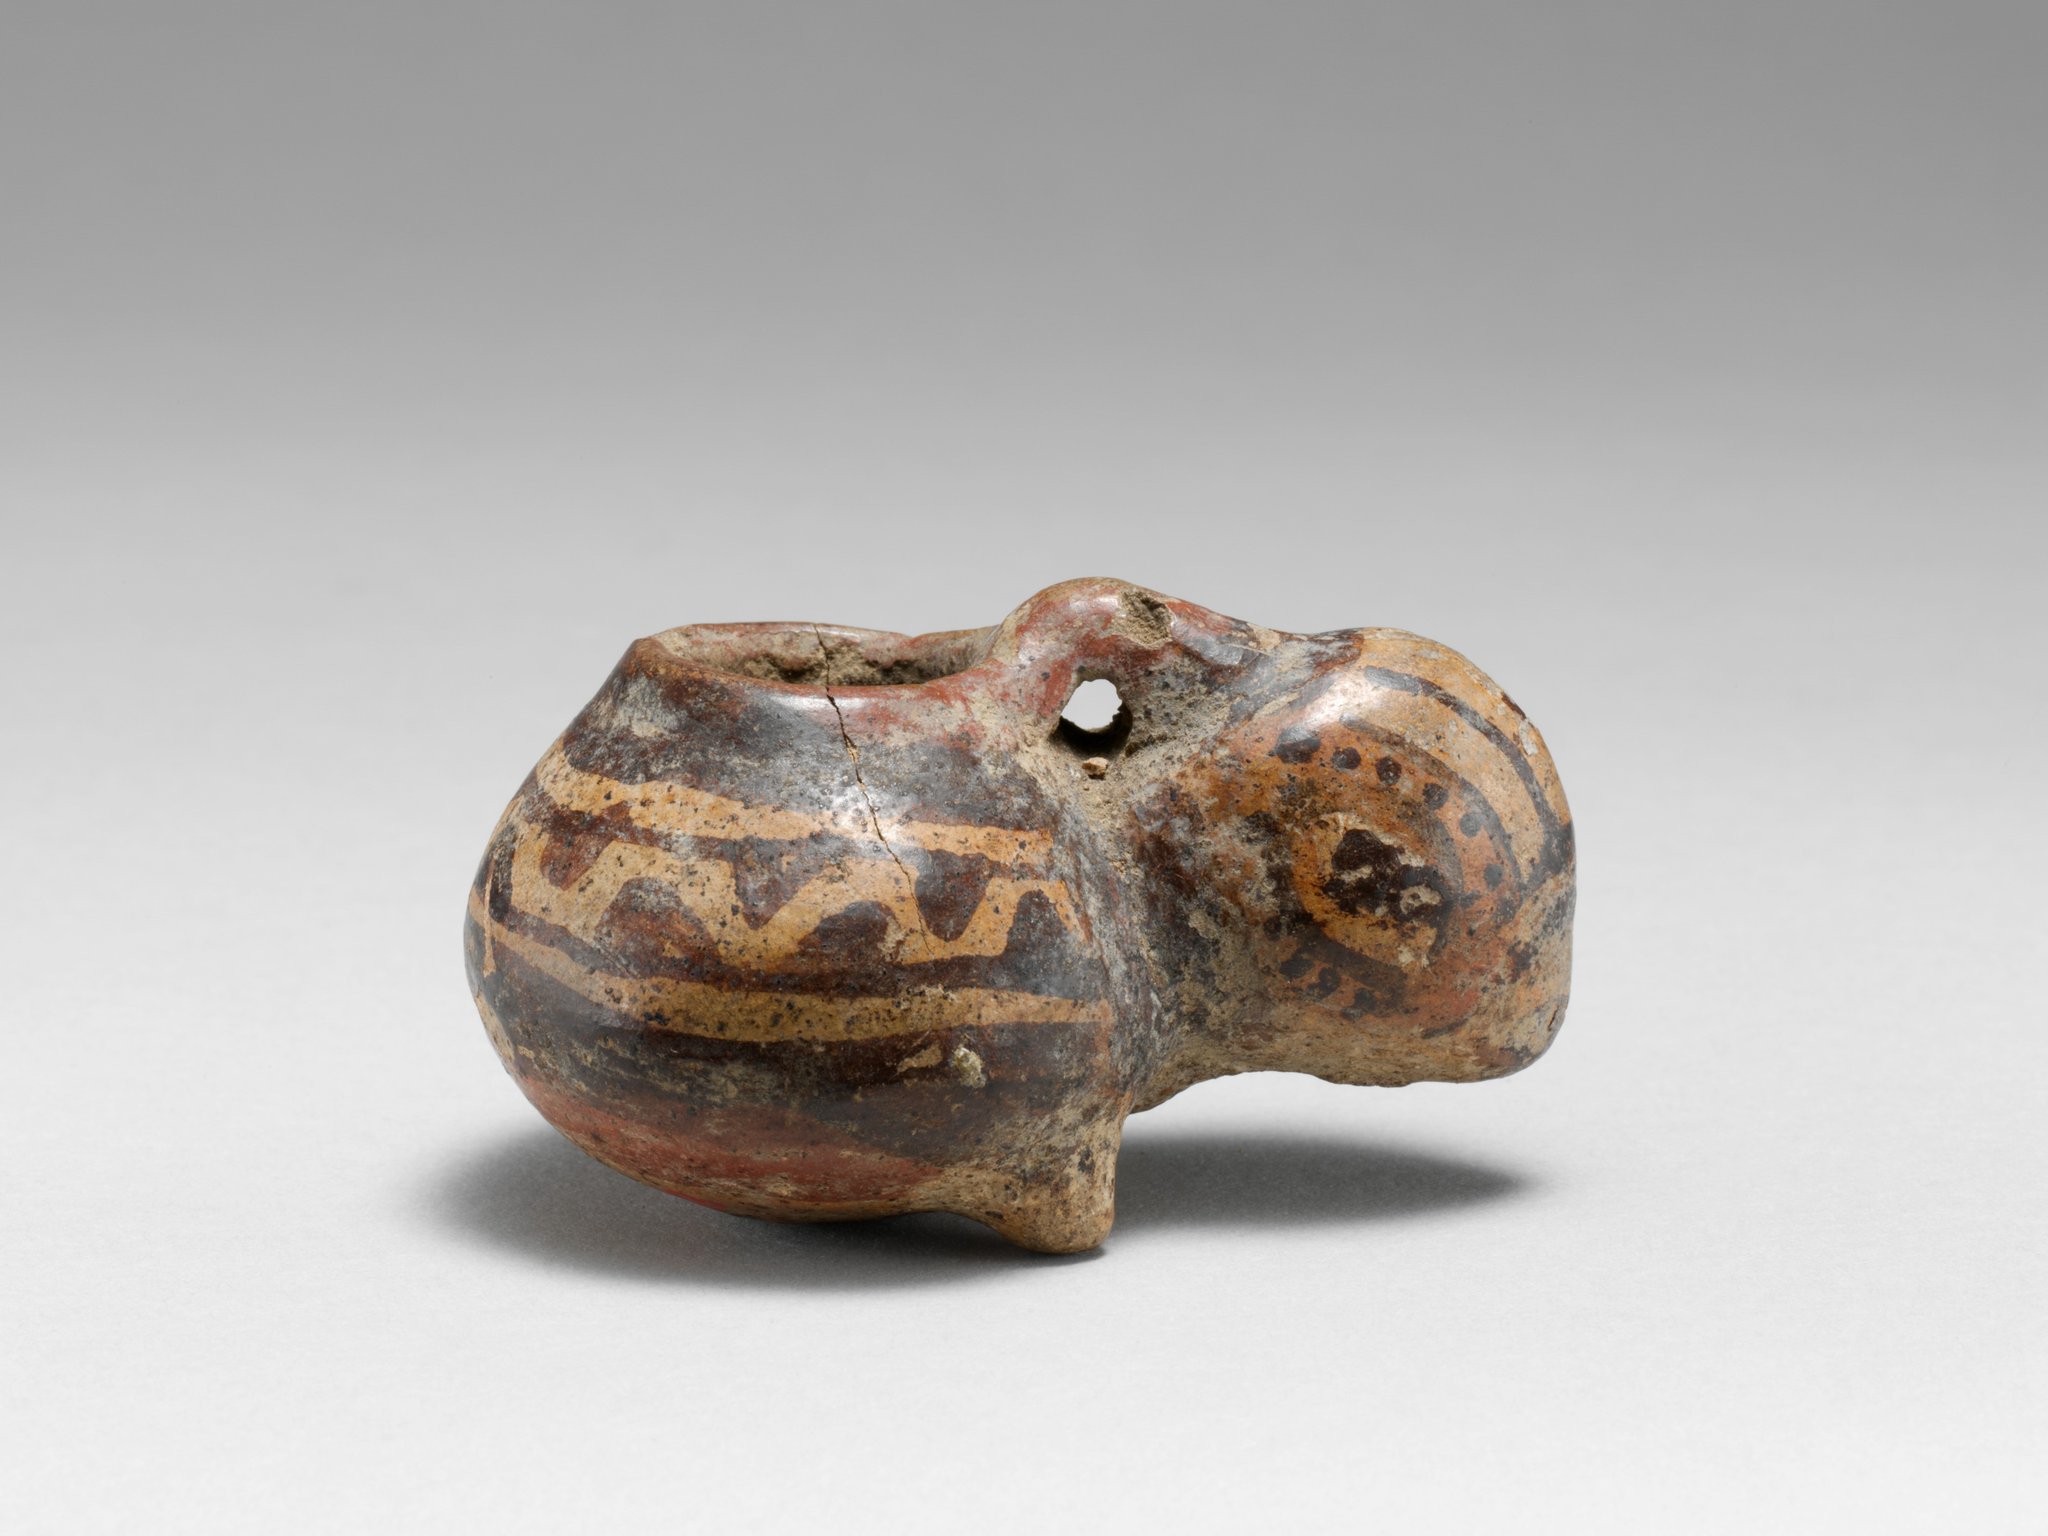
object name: pottery whistle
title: Pottery Whistle?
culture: costa rican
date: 800-1526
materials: clay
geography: costa rica